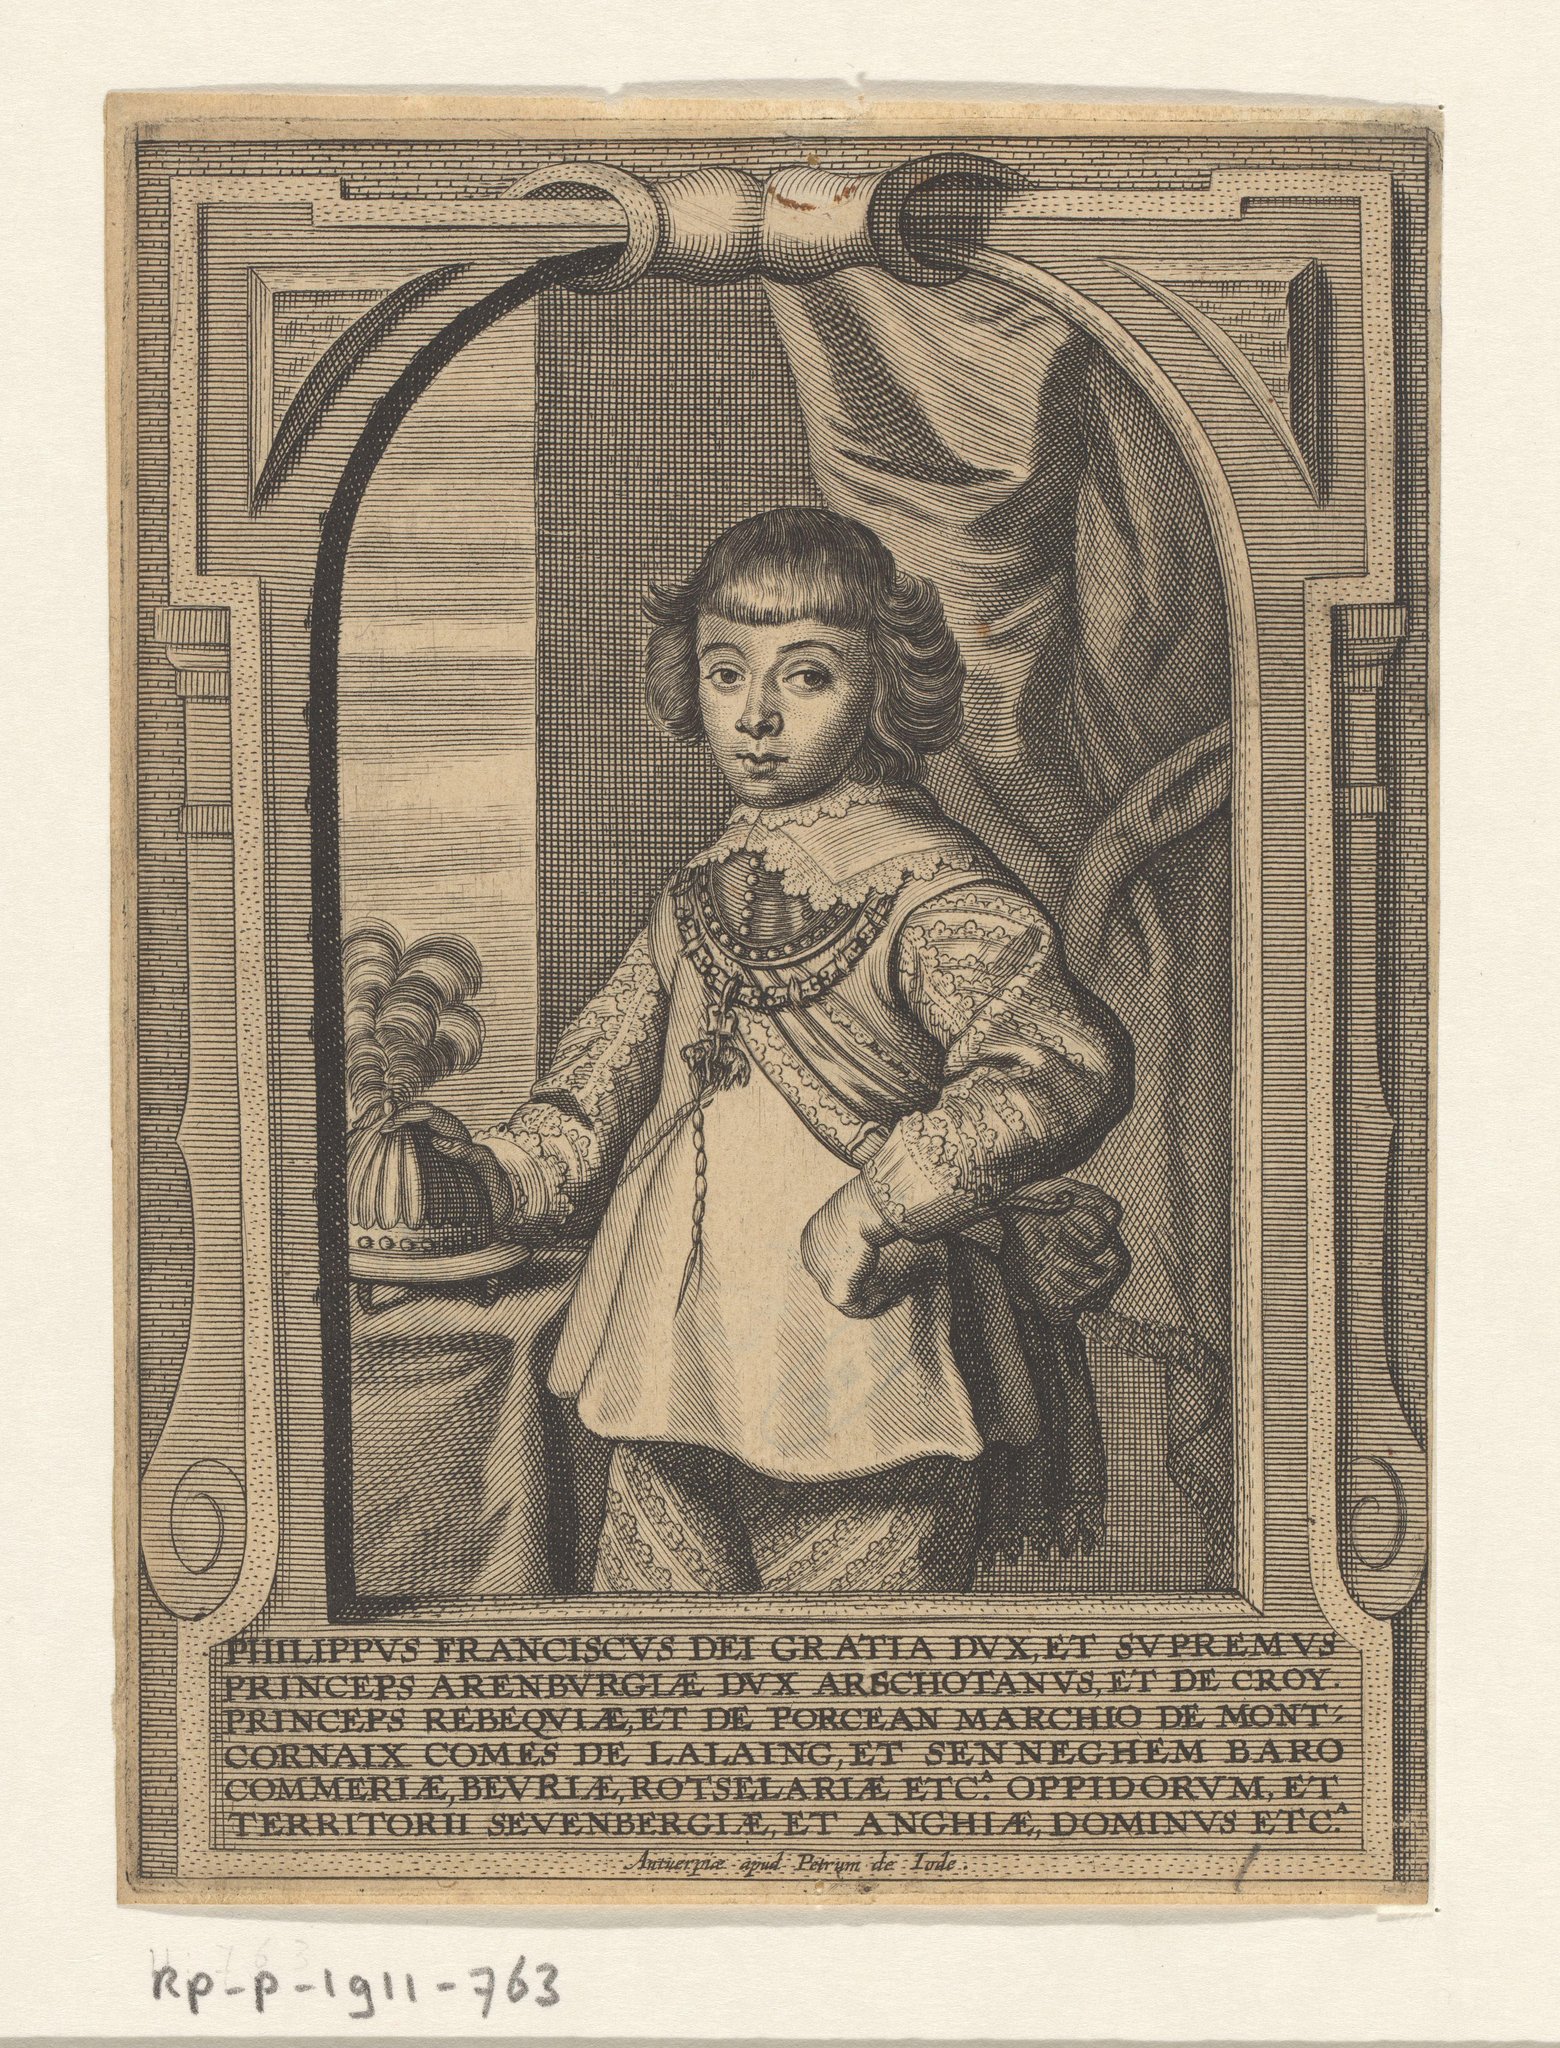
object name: print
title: Portret van Filips Frans van Arenberg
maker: pieter de jode (ii)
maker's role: draughtsman, print maker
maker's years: 1606-1674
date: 1646-1651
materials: paper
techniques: engraving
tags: helmet, historical persons, knighthood order of the golden fleece, ornament derived from architectural details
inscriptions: collector's mark: Lugt 2228